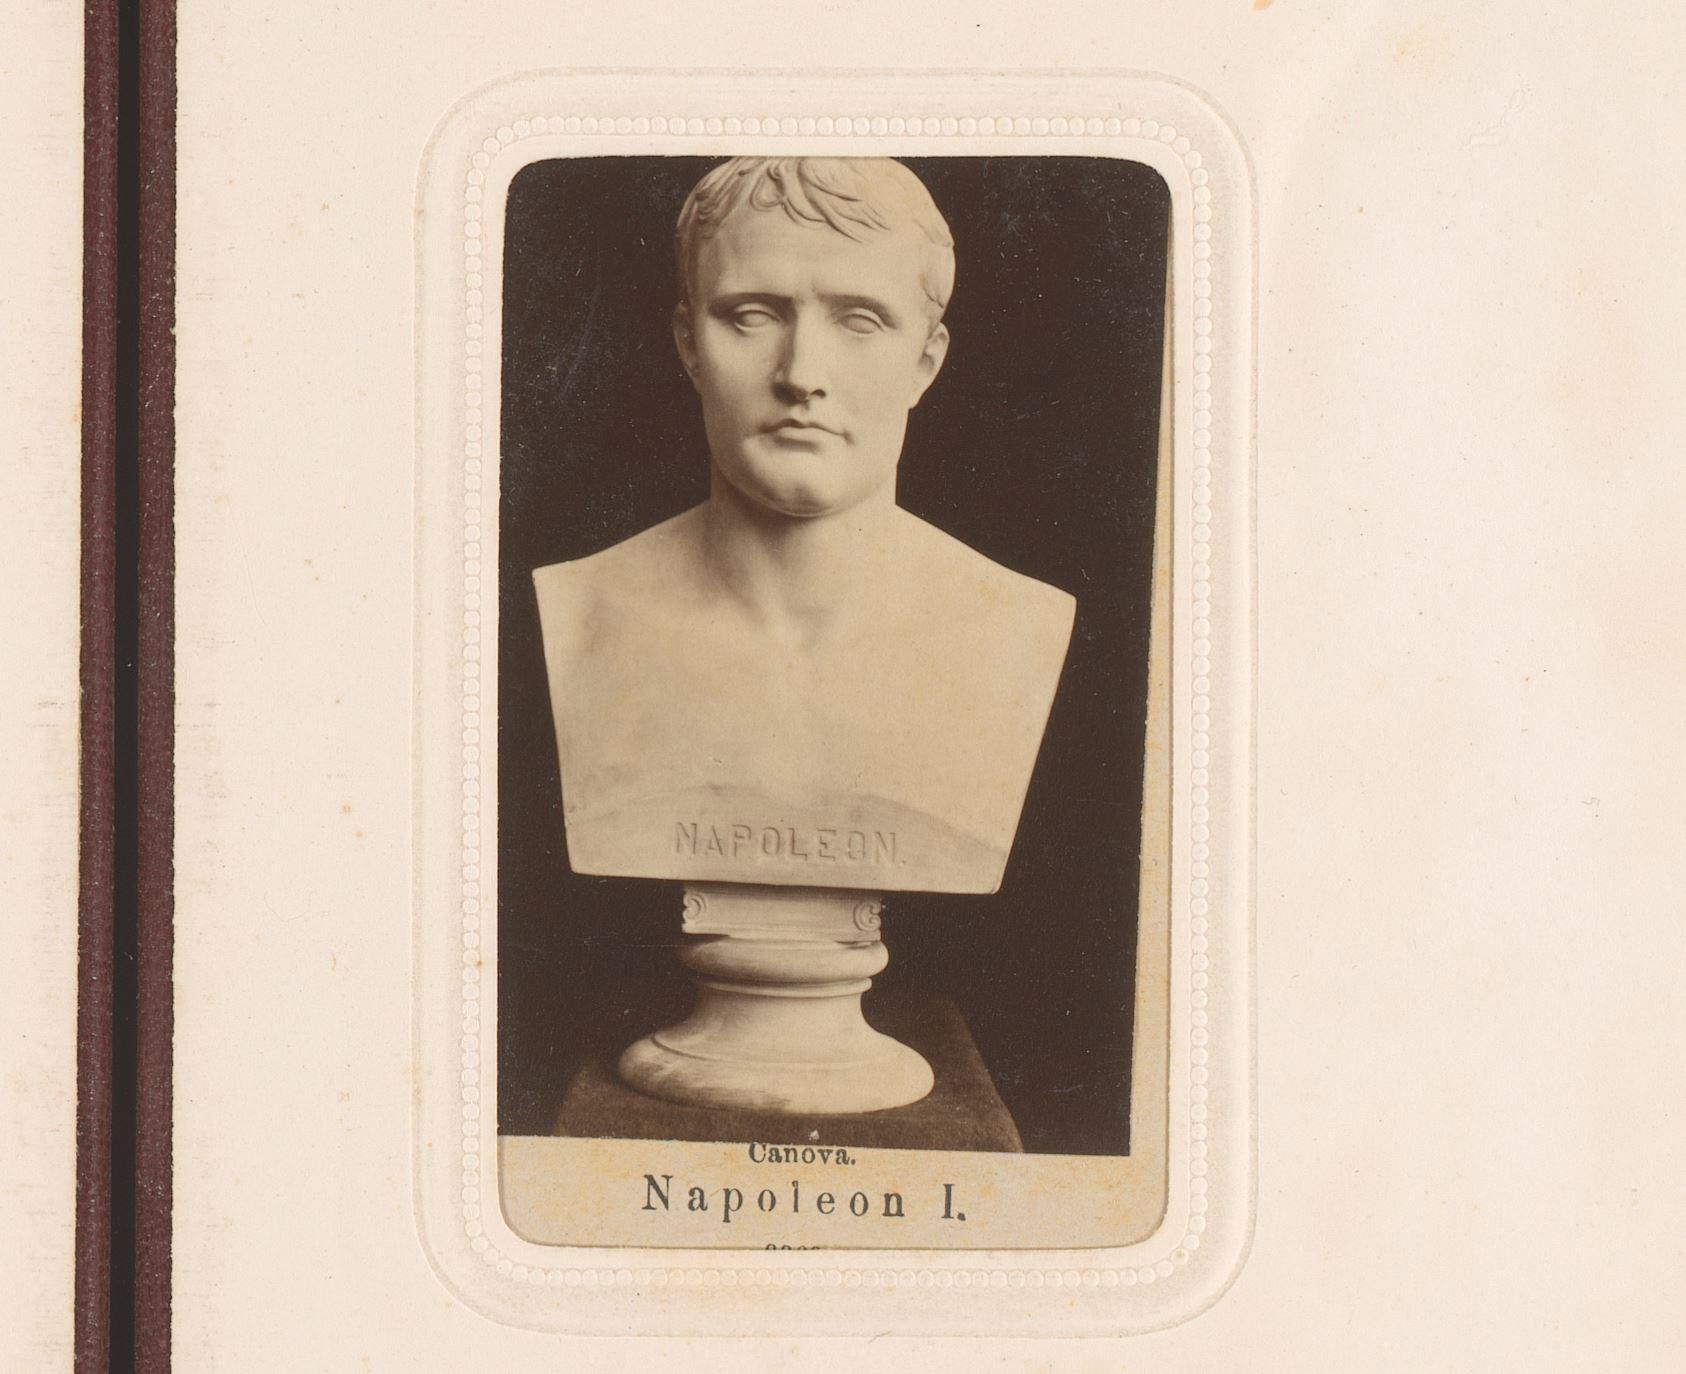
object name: album leaf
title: Sculptuur van Napoleon I door Antonio Canova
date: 1860-1890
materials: cardboard, photographic support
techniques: albumen print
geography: berlin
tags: napoleon i (emperor of the french), historical persons, emperor, piece of sculpture, reproduction of a piece of sculpture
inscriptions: inscription: ‘Canova./ Napoleon I./ 2369.’